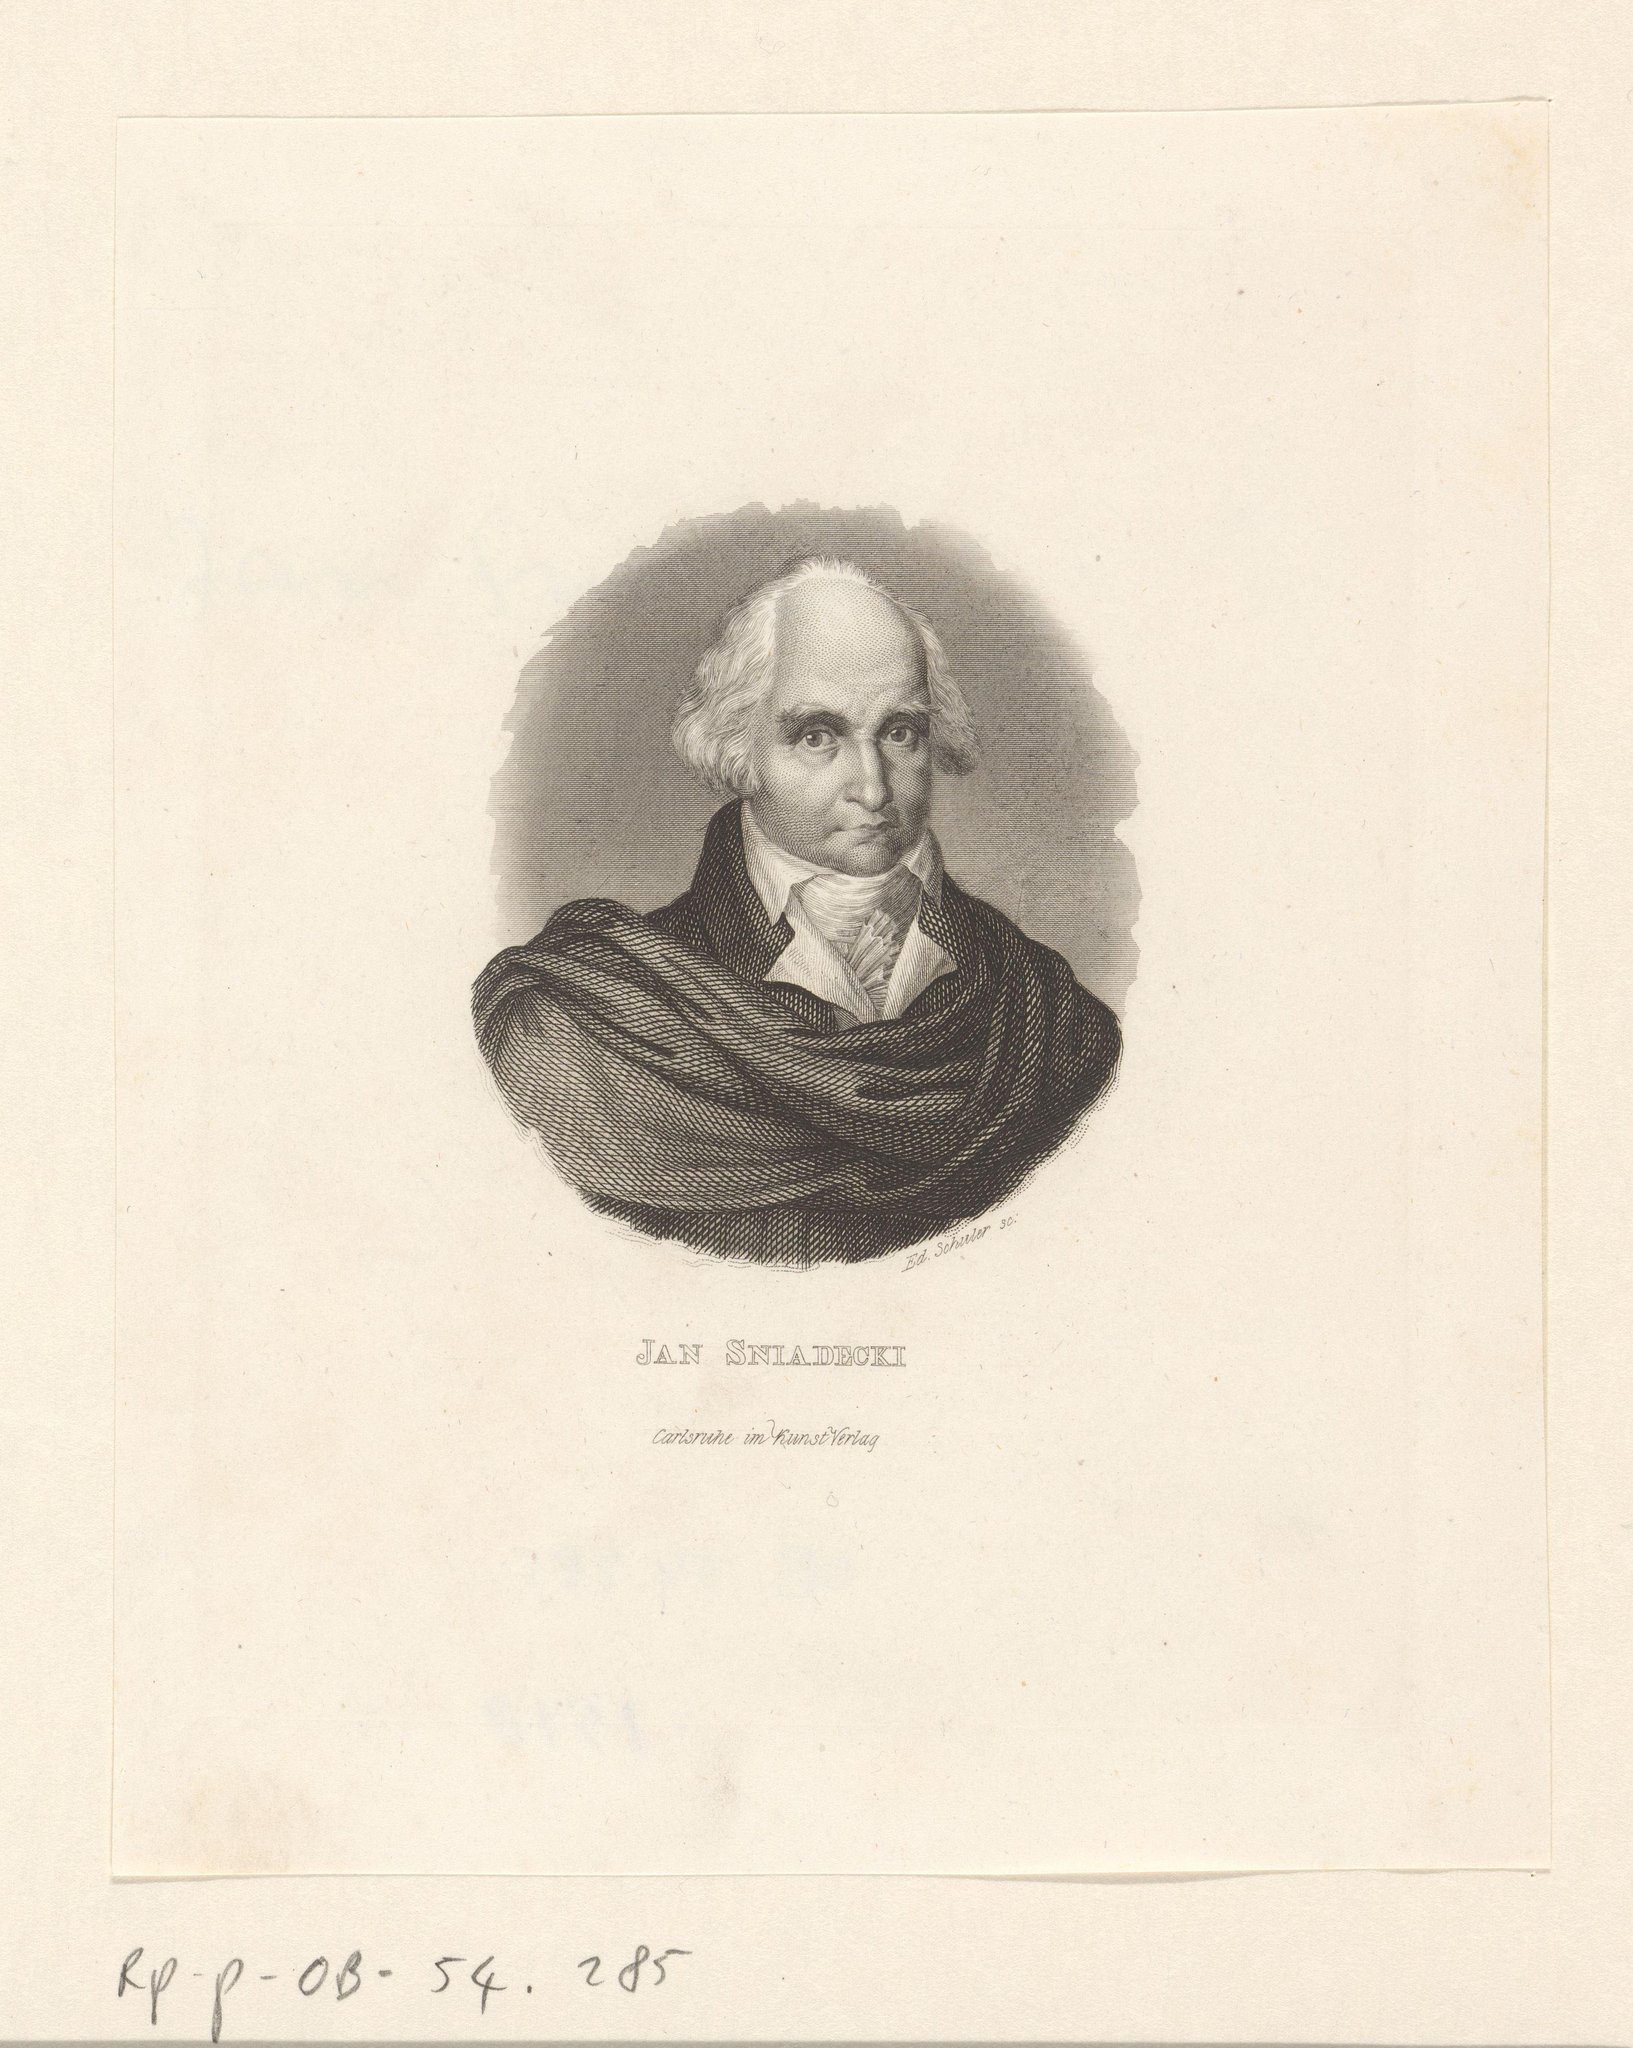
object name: print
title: Portret van Jan Śniadecki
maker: edouard schuler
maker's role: print maker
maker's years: 1806-1882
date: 1816-1882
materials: paper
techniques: engraving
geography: karlsruhe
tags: historical persons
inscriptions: collector's mark: Lugt 2228